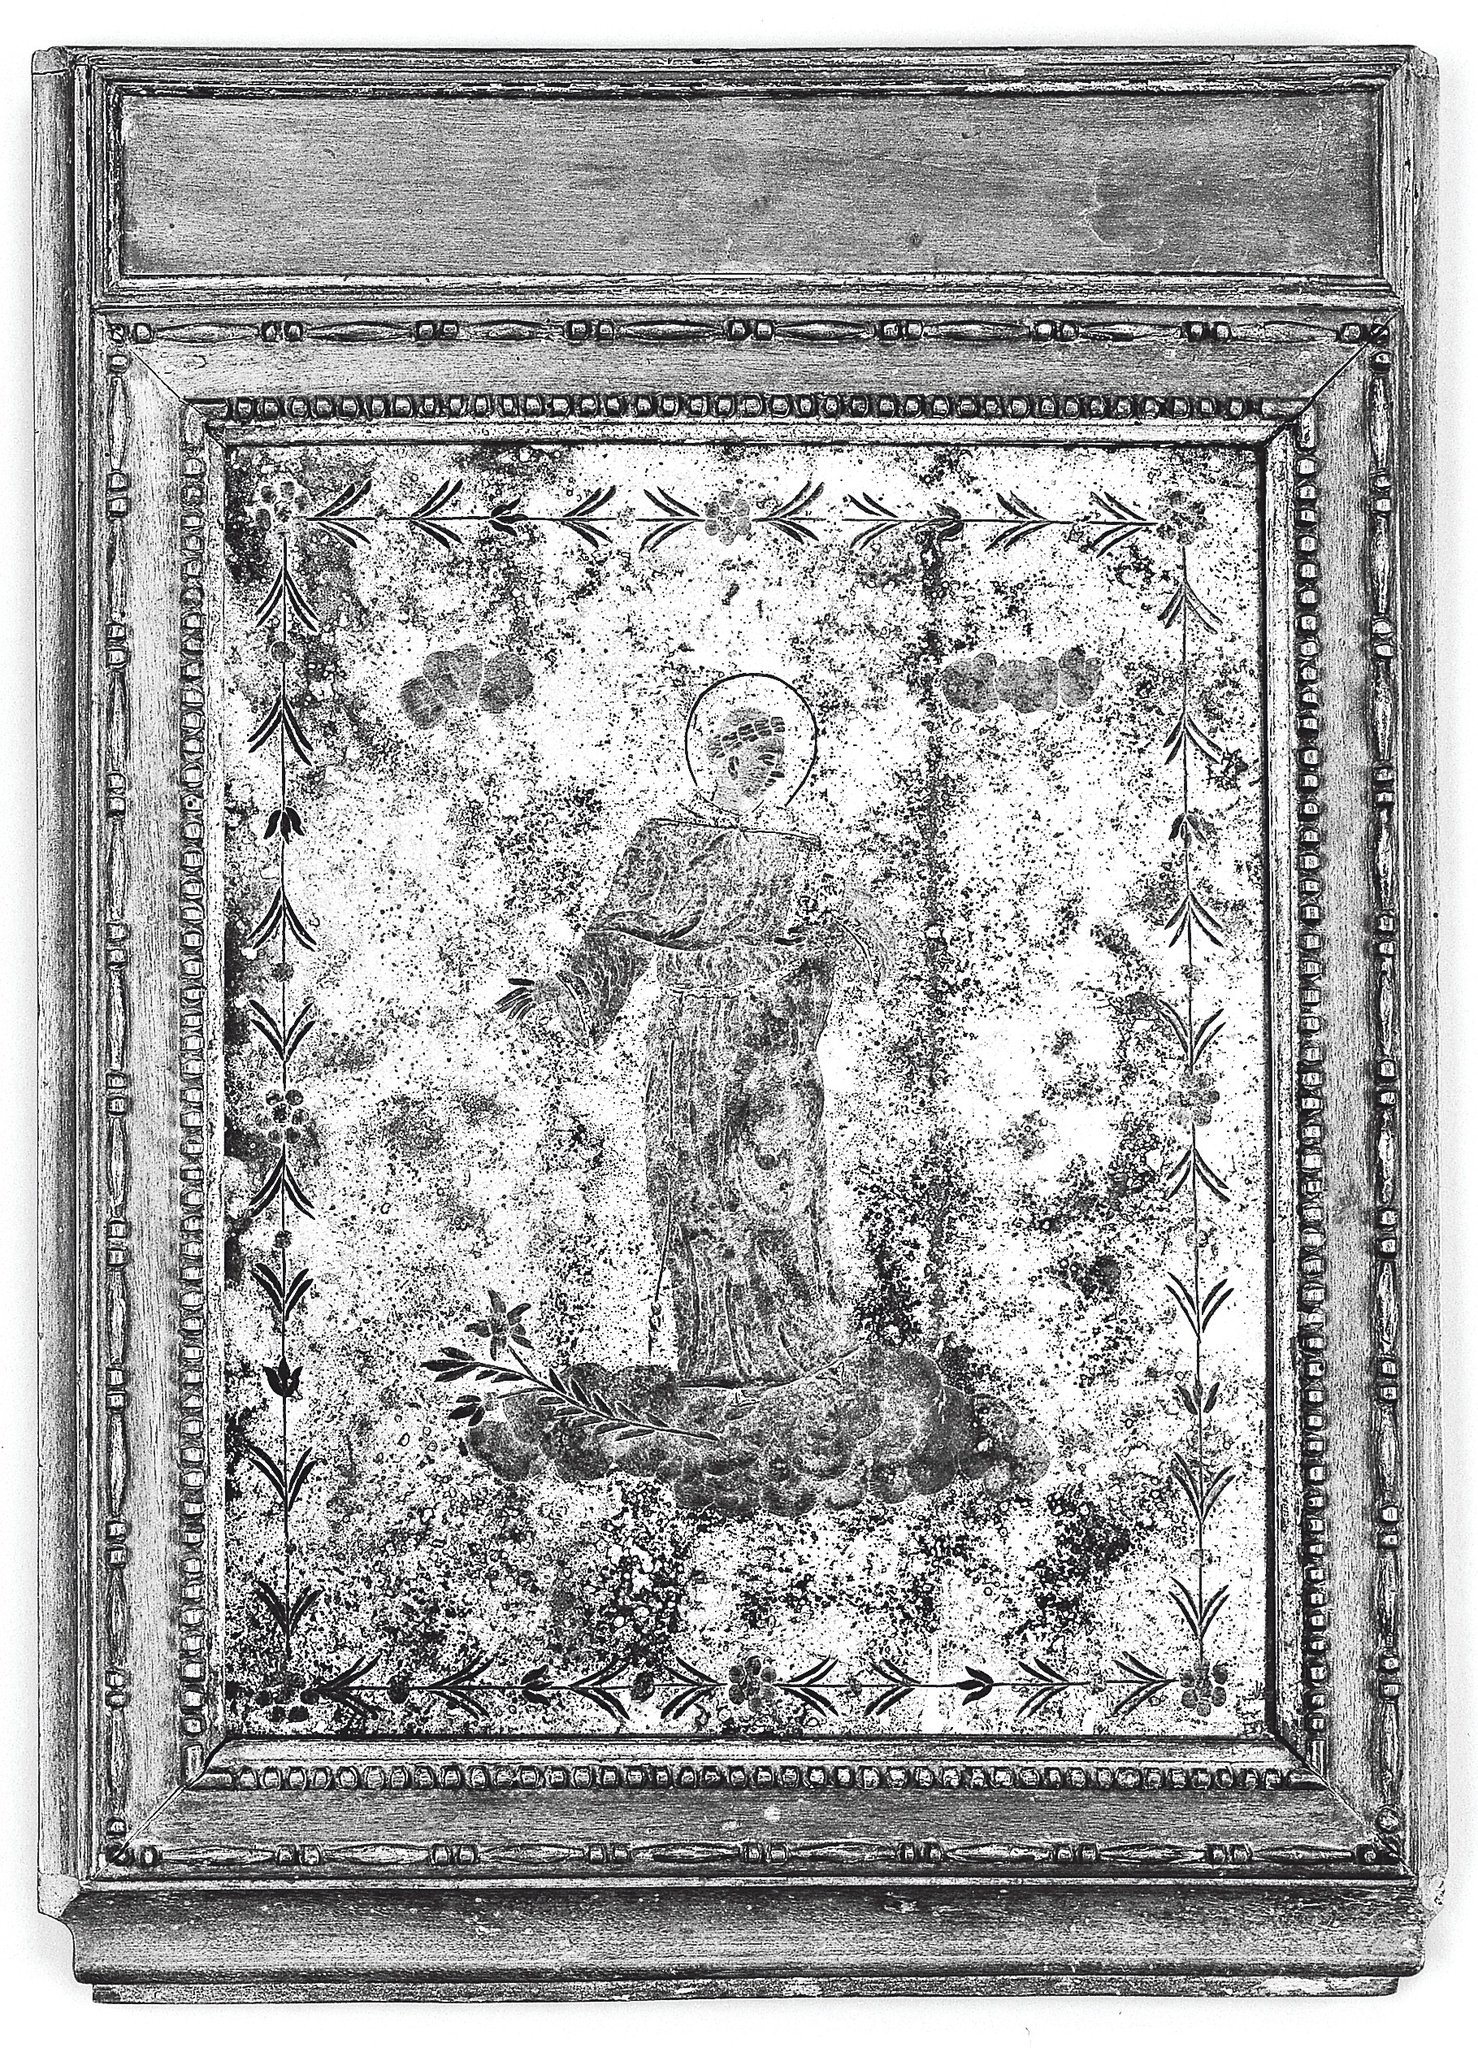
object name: frame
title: Mirror frame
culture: italian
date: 1767-1800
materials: wood